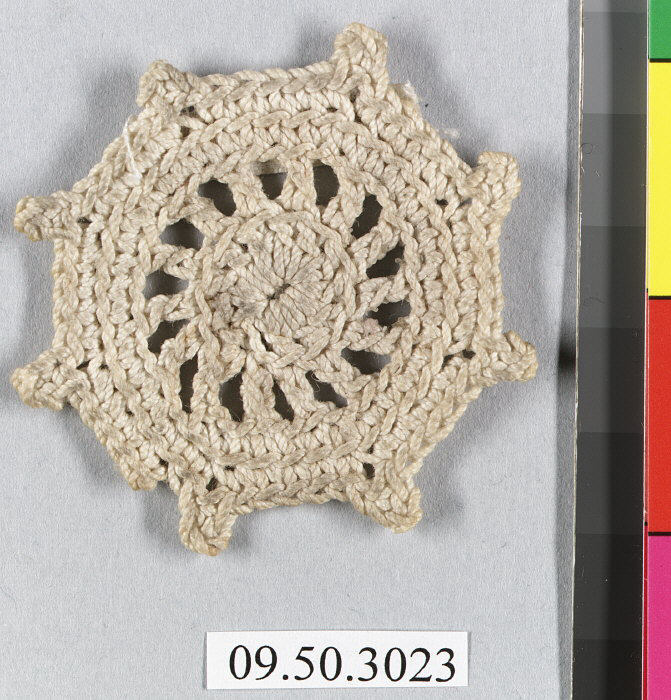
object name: sample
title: Crochet Work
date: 1801-1900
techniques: crochet